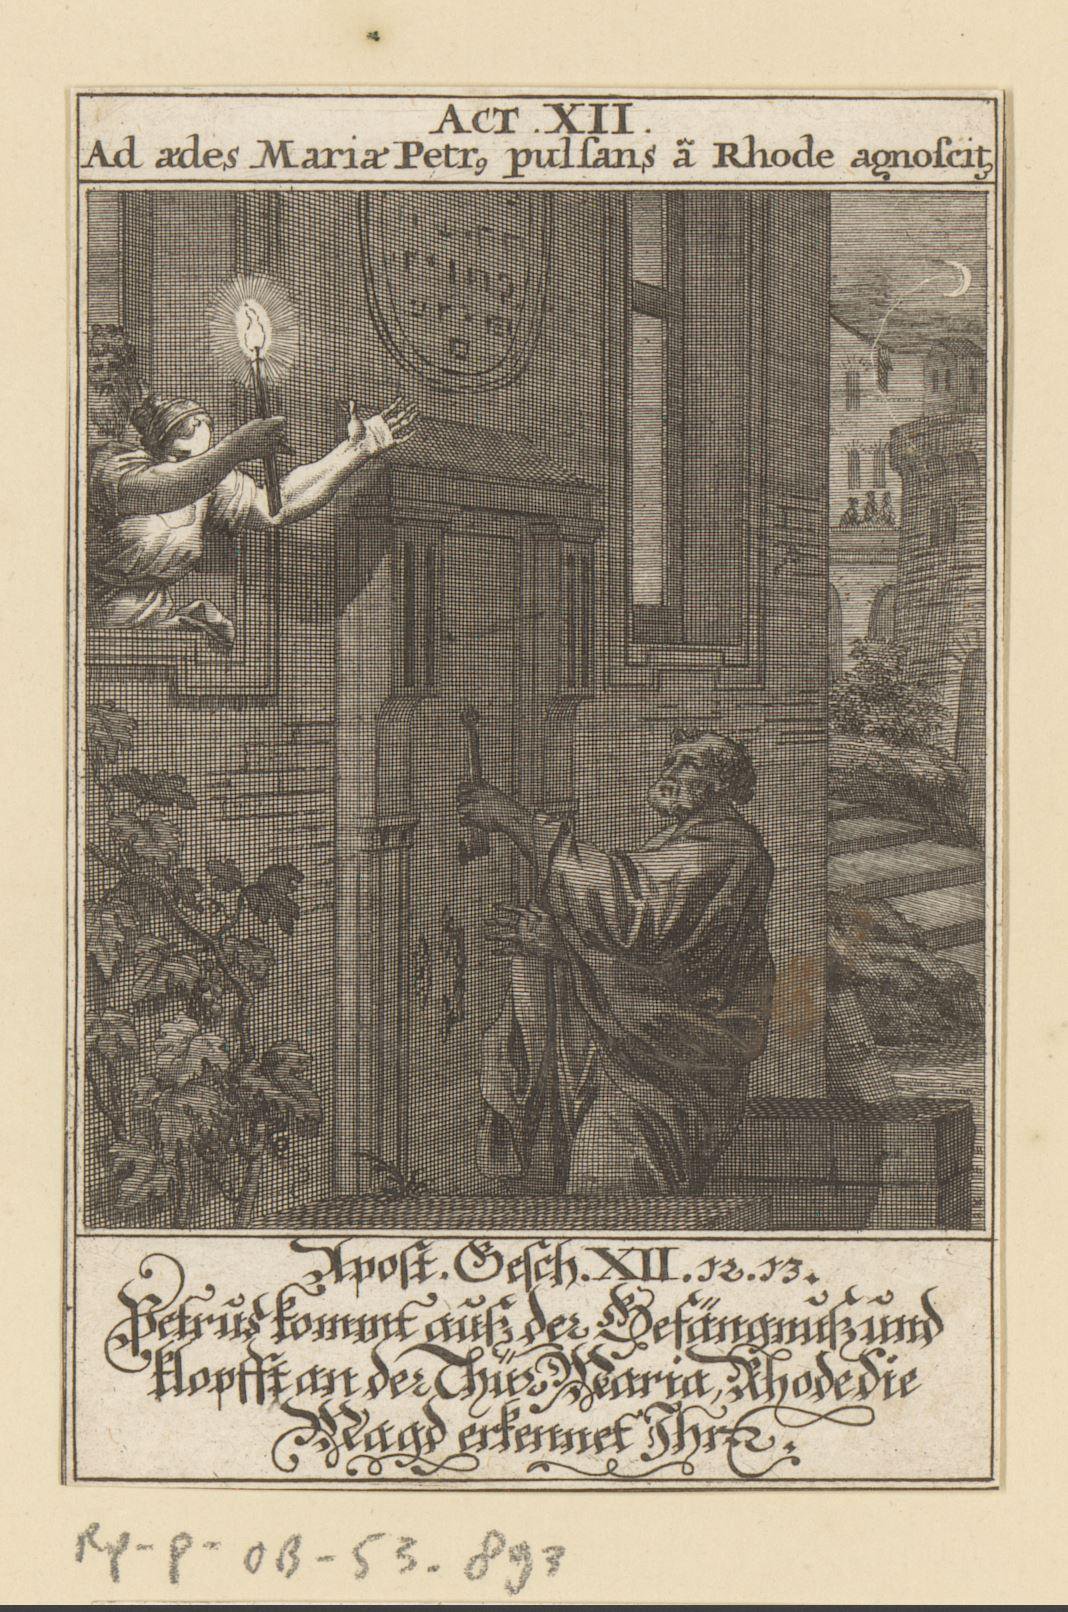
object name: print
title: Rhode, de dienstmaagd van Maria, herkent Petrus die 's nachts aan de deur klopt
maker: Anonymous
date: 1697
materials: paper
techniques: etching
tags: rhoda, the maidservant, recognizes peter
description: Prent ook gebruikt in: Biblia ectypa : Bildnussen auss Heiliger Schrifft. Regensburg: Chr. Wiegel, 1697.